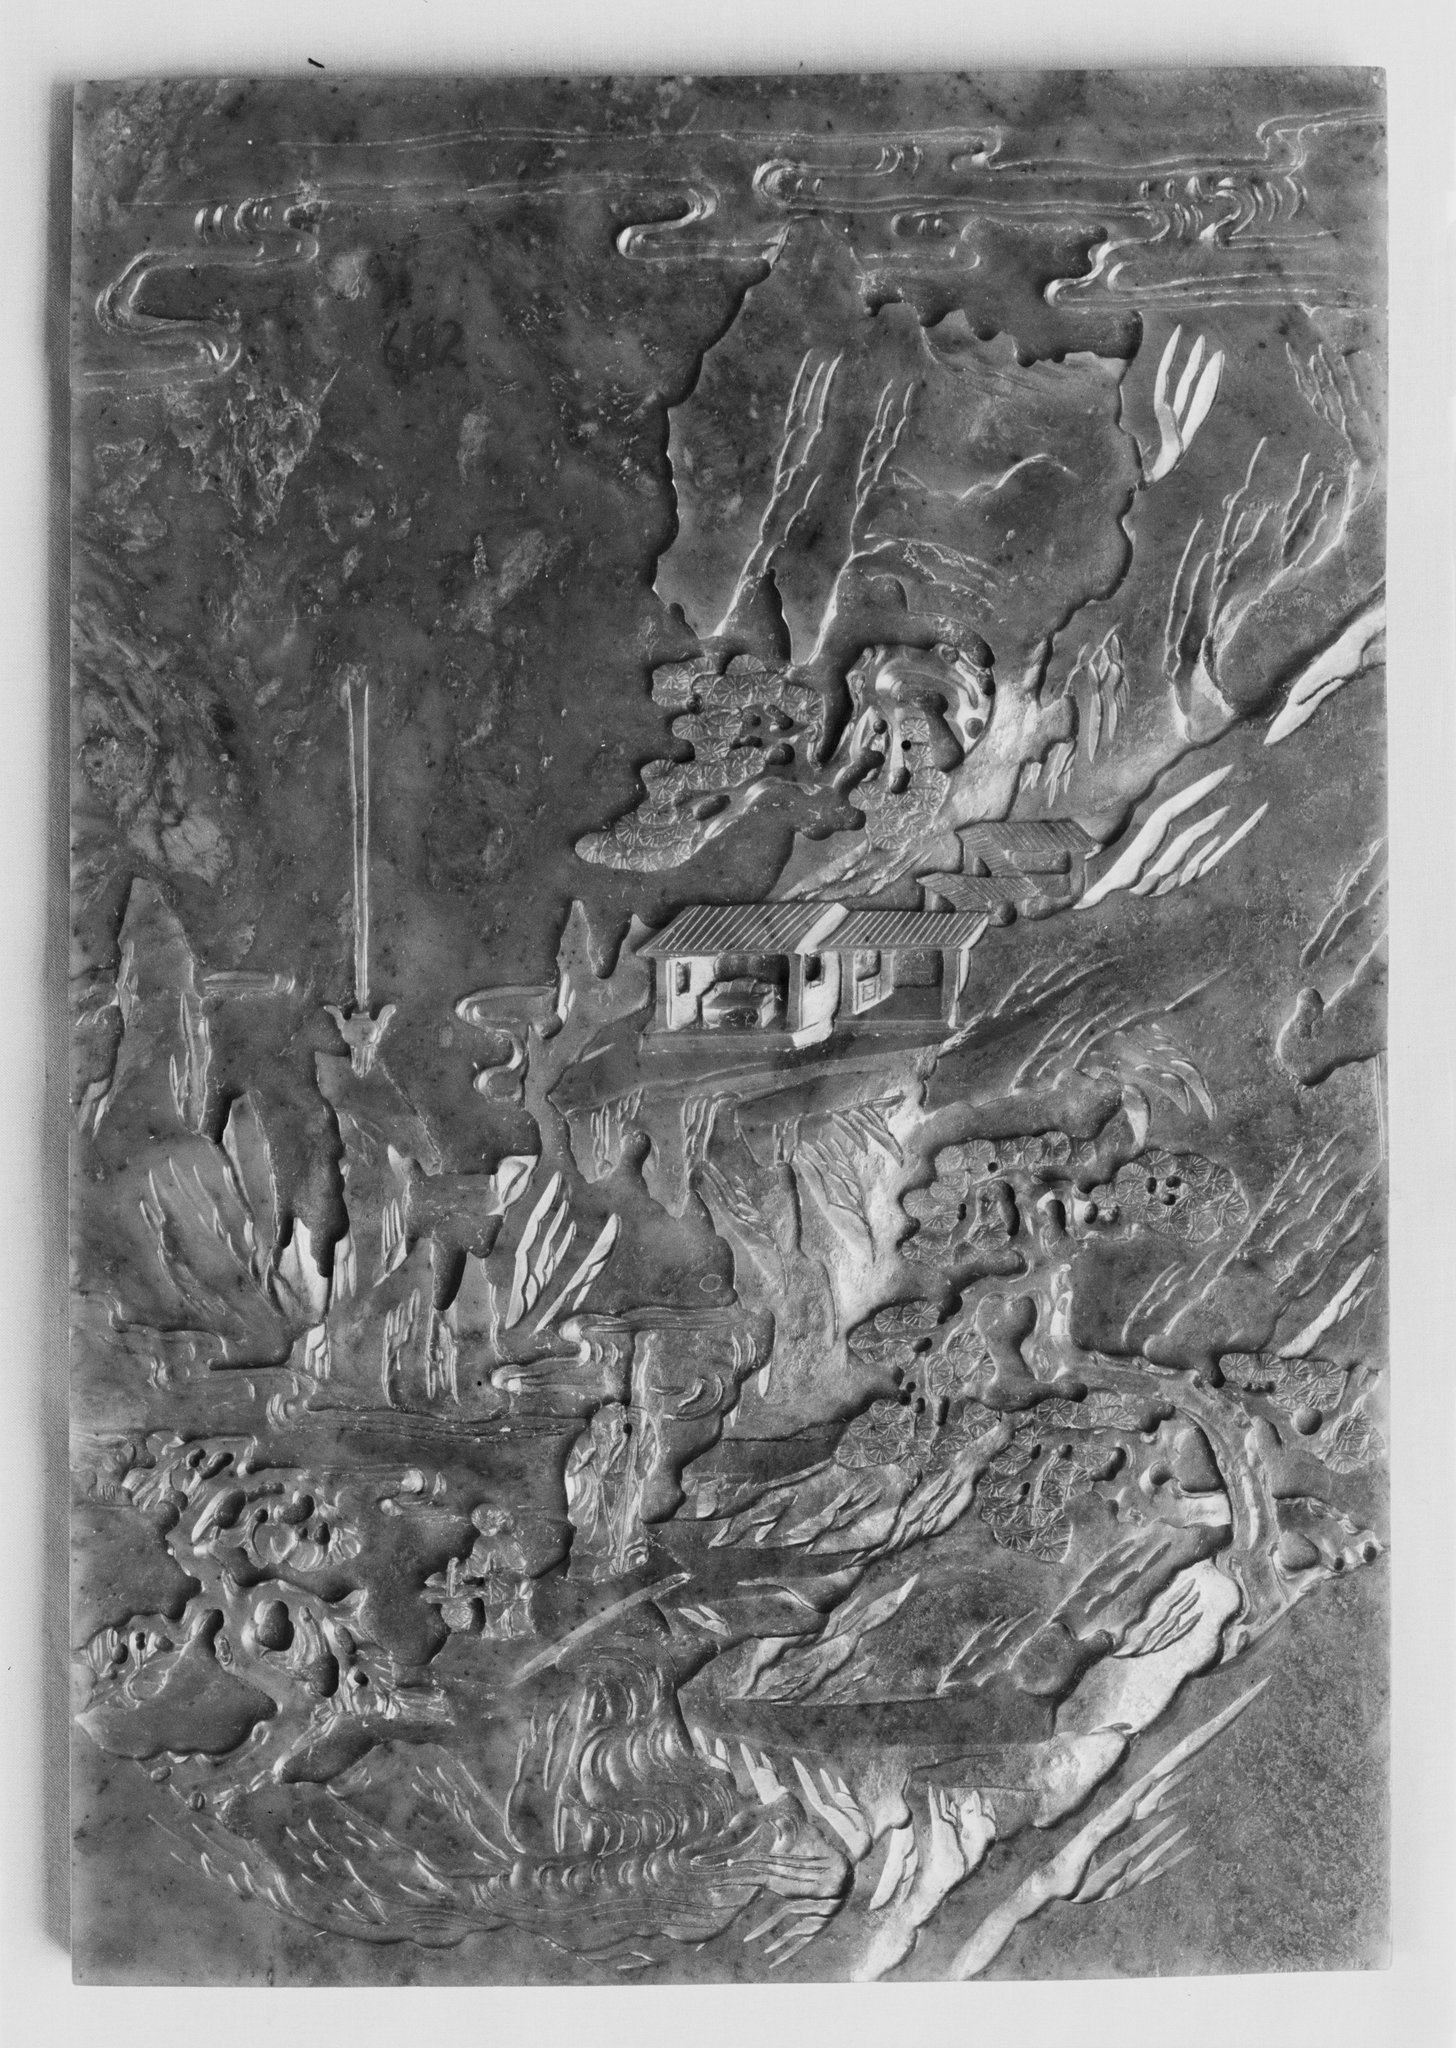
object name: table screen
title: Table Screen with land of immortals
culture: chinese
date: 1701-1900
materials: jade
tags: trees